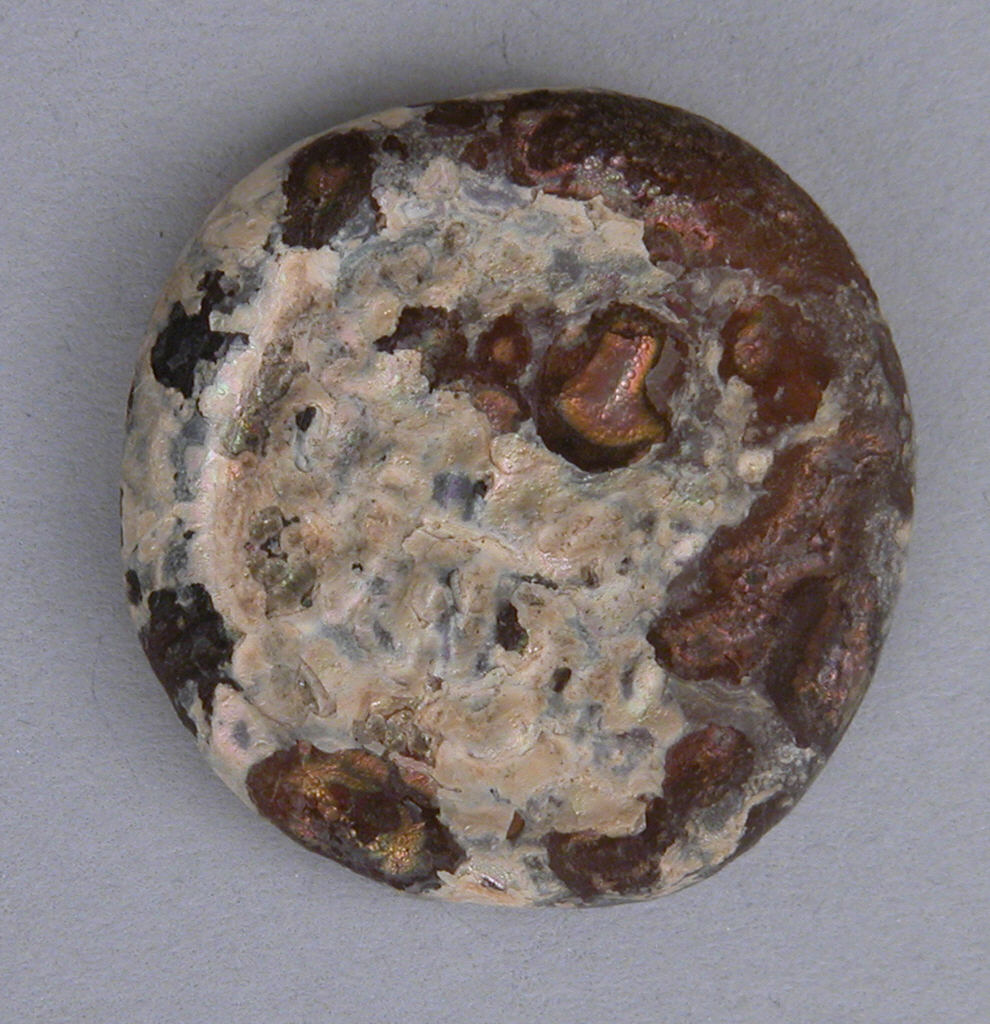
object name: coin weight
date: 1001-1100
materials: glass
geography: egypt